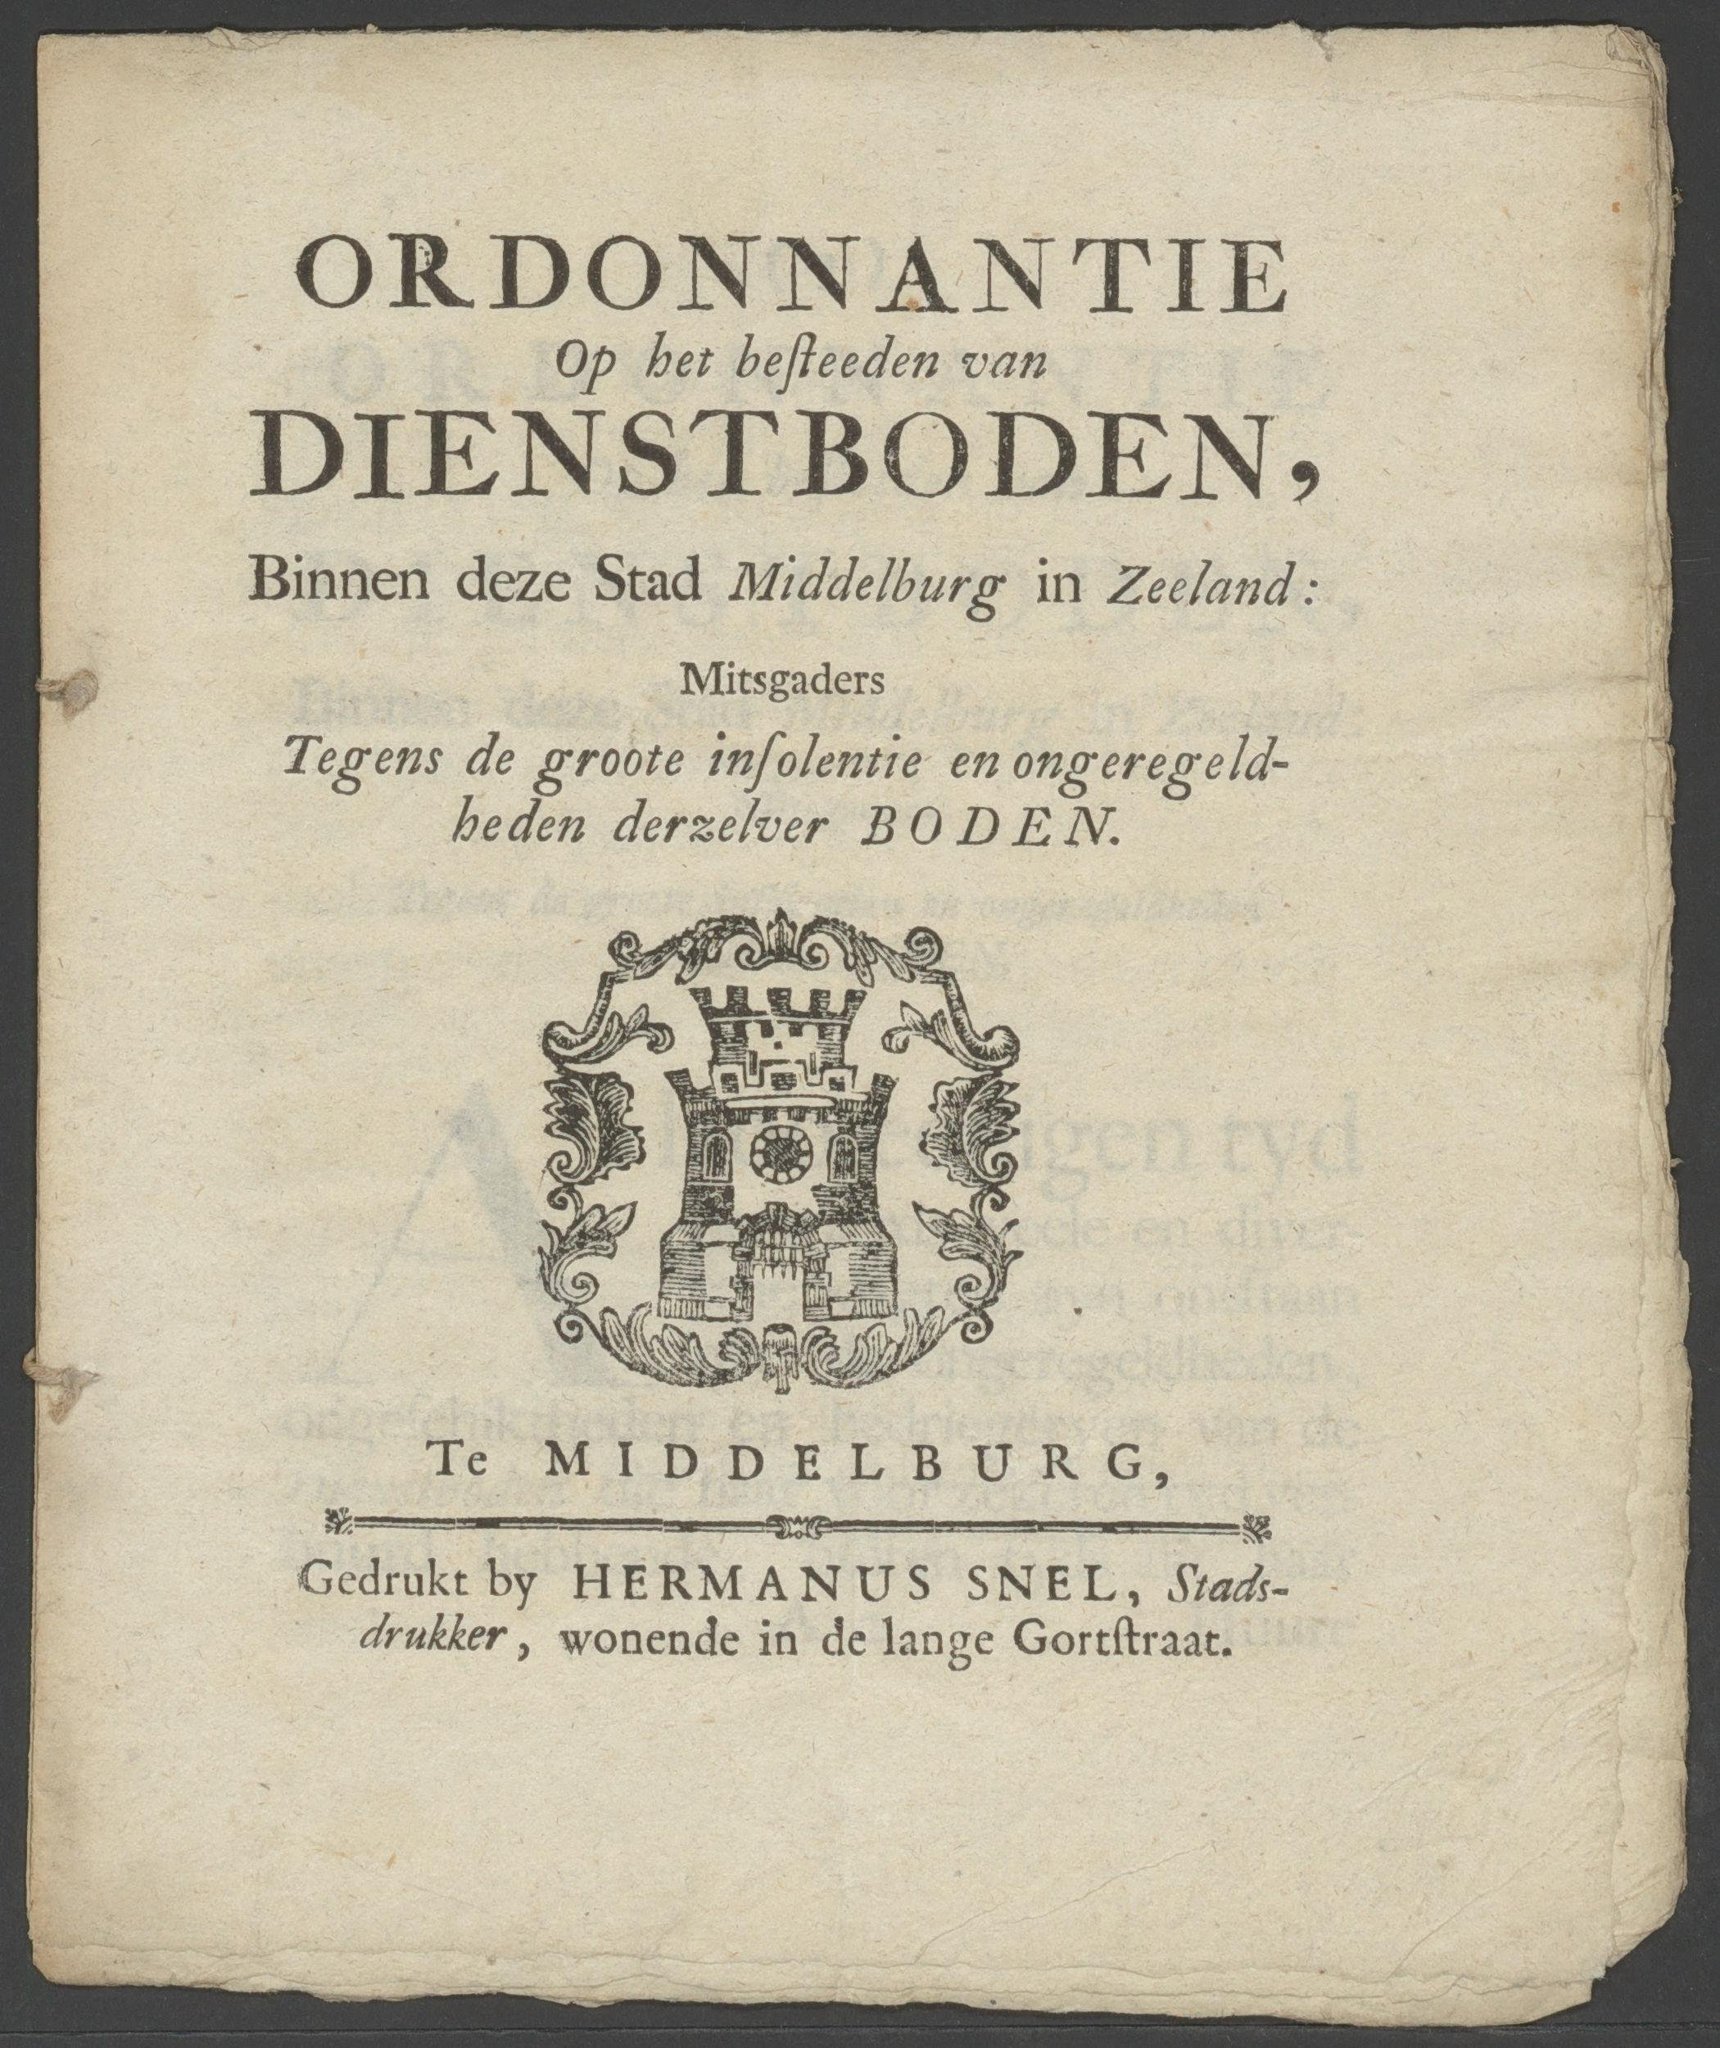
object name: pamphlet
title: Reglement voor dienstboden, Middelburg 1791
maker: hermanus snel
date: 1791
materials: paper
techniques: letterpress printing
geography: middelburg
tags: maid ~ house personnel, middelburg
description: Reglement voor dienstboden, Middelburg, 1791. Op de voorpagina het wapen van Middelburg. Boekje bestaande uit acht bladen. Op achterzijde de naam van de secretaris Pl. Changuion. Onderwerpsrubrieken binnen de Atlas Zeden en Gewoonten: Beroep en bedrijf. Vrouwelijk beroep en bedrijf. Dienstboden.